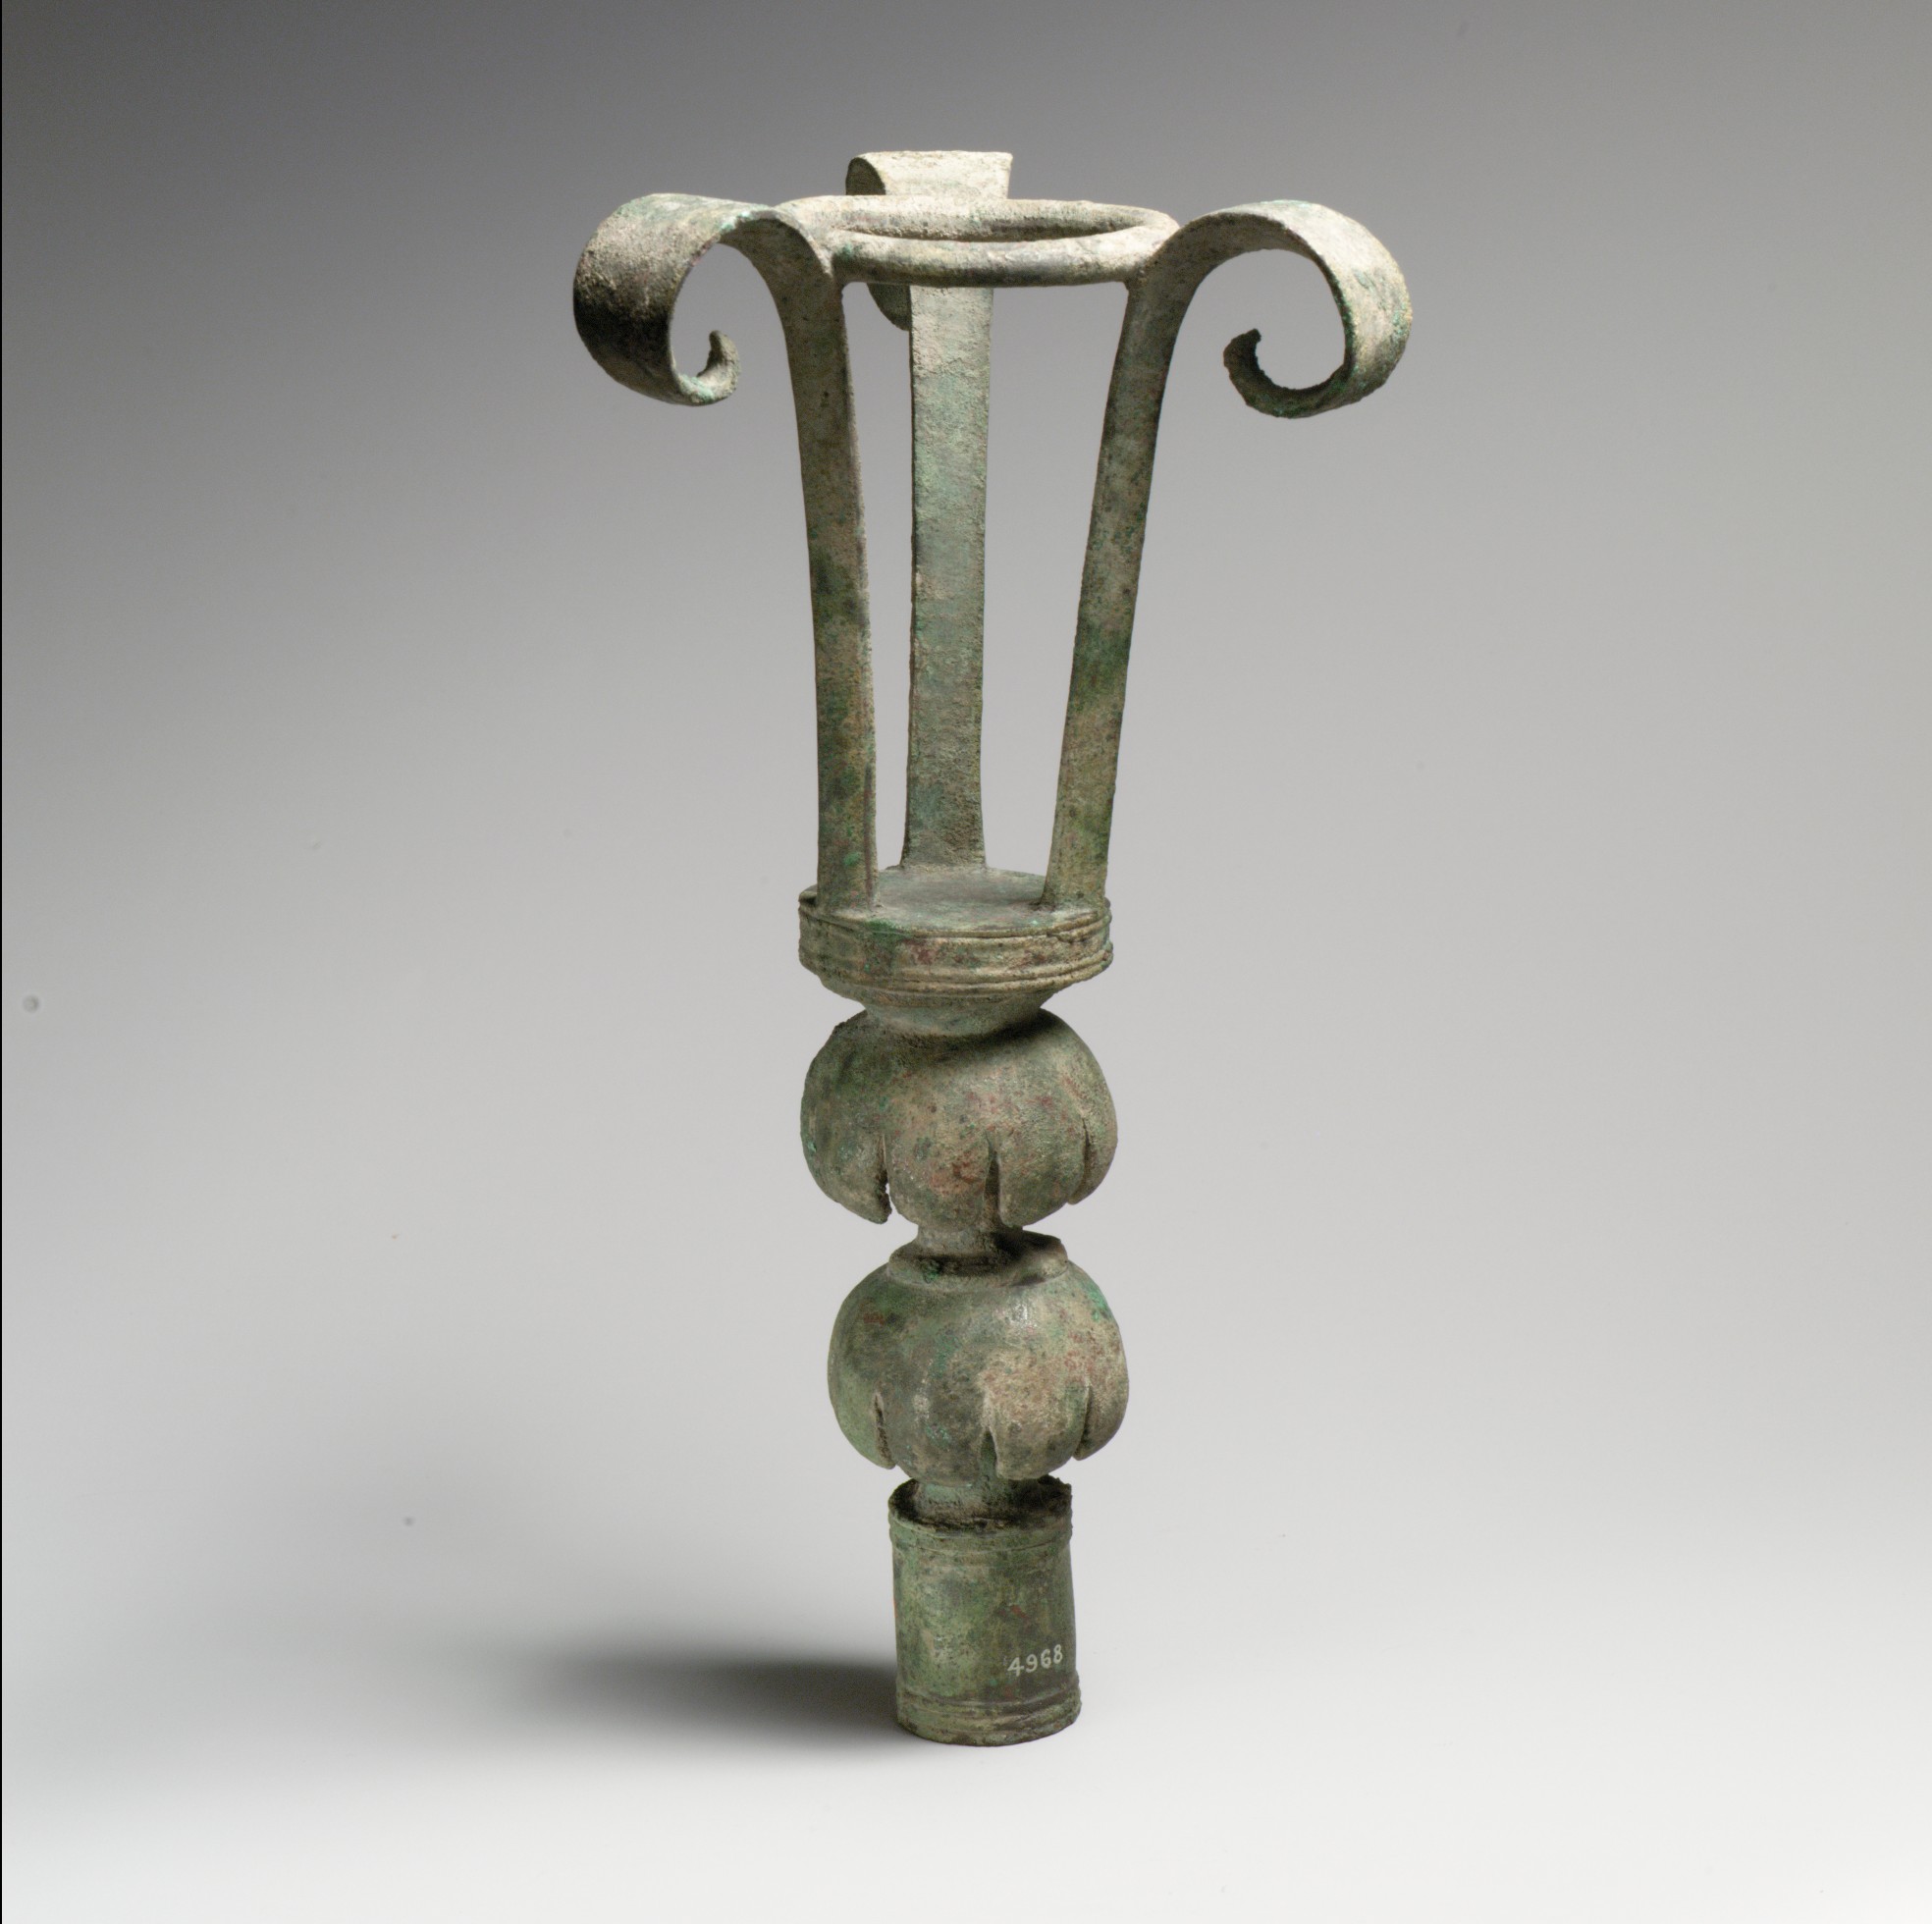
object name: lampstand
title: Bronze lamp holder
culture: cypriot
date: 600-501 BCE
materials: bronze